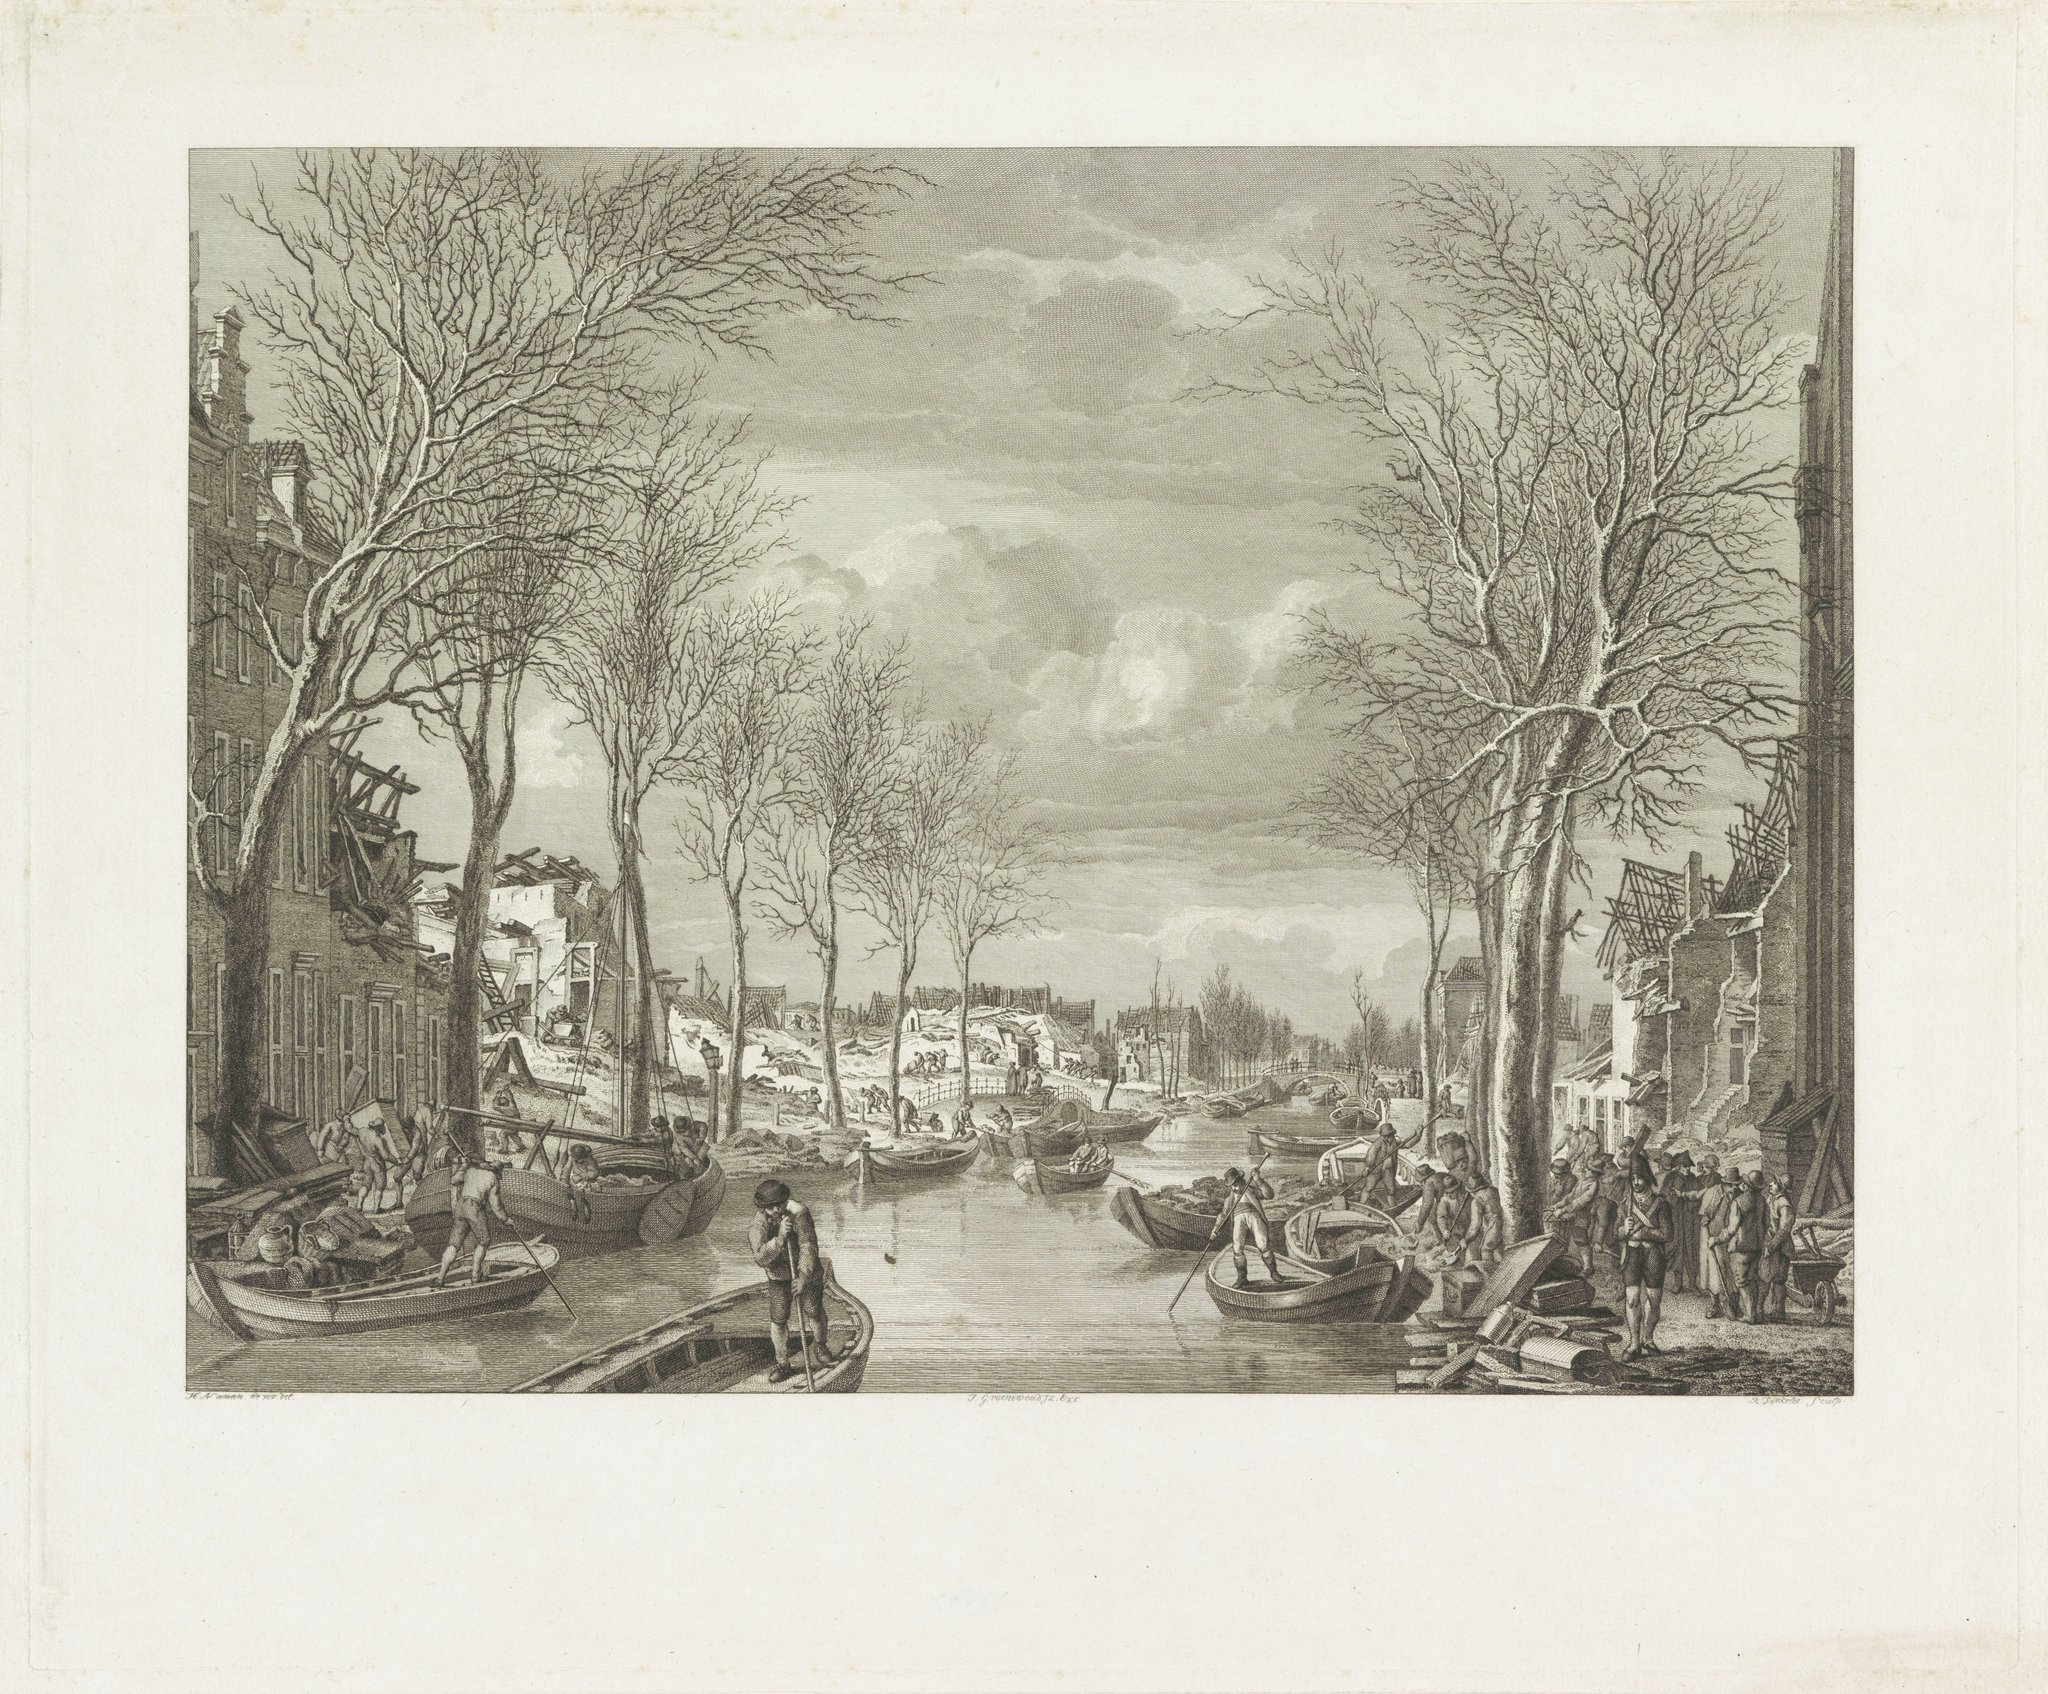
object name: print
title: Herstelwerk op het Steenschuur na de ramp, 1807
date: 1807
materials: paper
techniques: engraving, etching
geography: leiden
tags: gunpowder disaster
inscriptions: collector's mark: Lugt 2228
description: Gezicht vanaf de Groenebrug op de herstelwerkzaamheden in het verwoeste gebied na de buskruitramp op het Steenschuur te Leiden op 12 januari 1807. Meerdere bootjes op het water, rechts is een klein stukje van de Saaihal te zien.